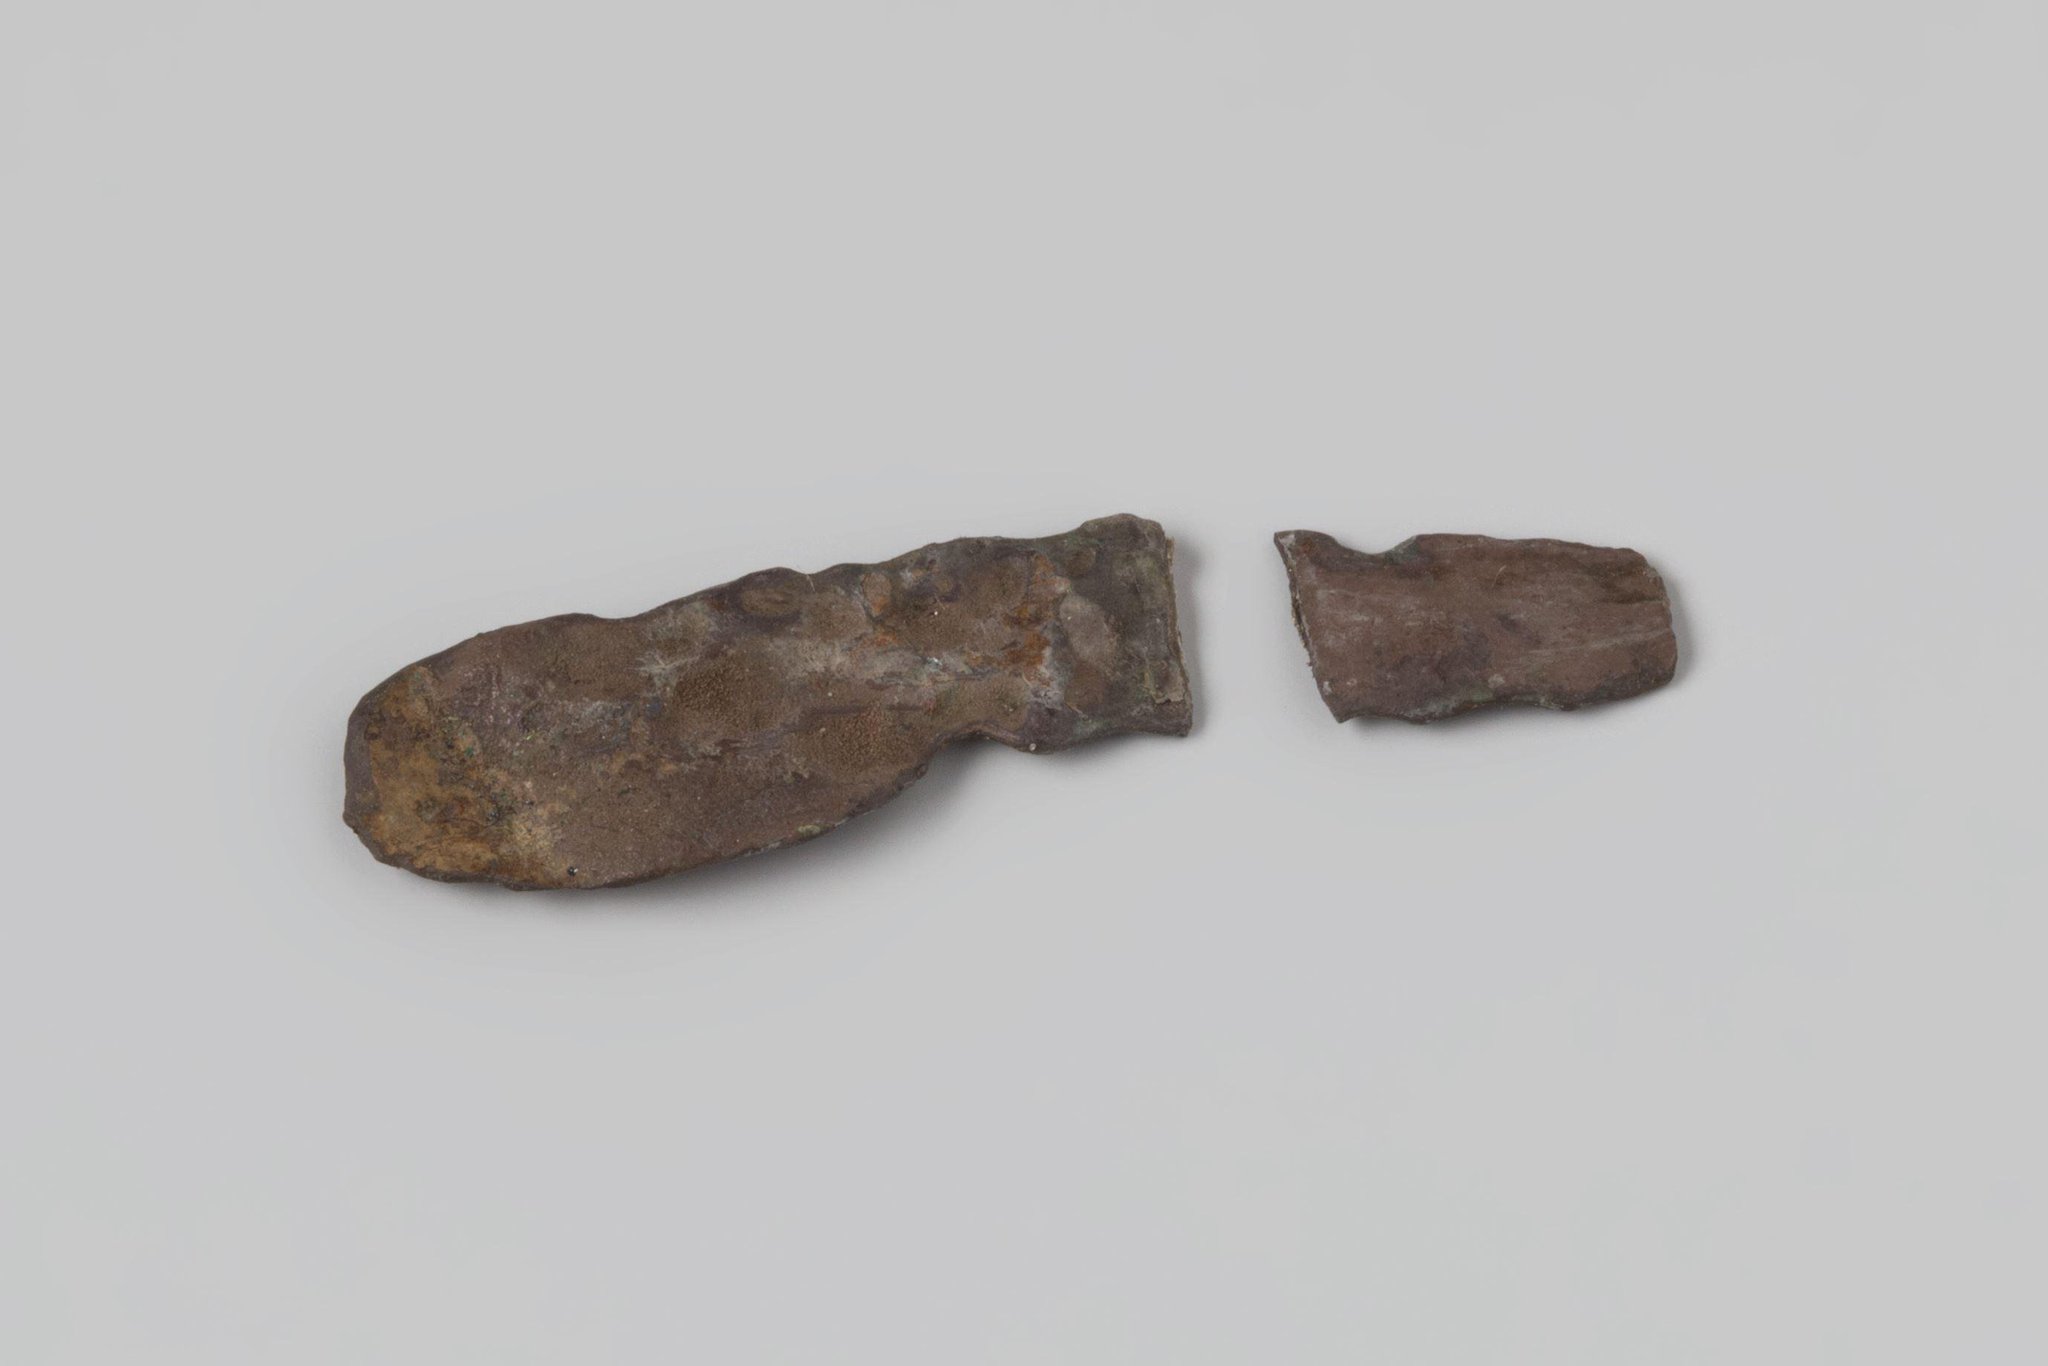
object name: scheepswrakvondst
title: Fragment van zilver uit het wrak van de Oost-Indiëvaarder Hollandia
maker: Anonymous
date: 1700-1743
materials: silver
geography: netherlands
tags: verenigde oostindische compagnie, hollandia (schip), annet